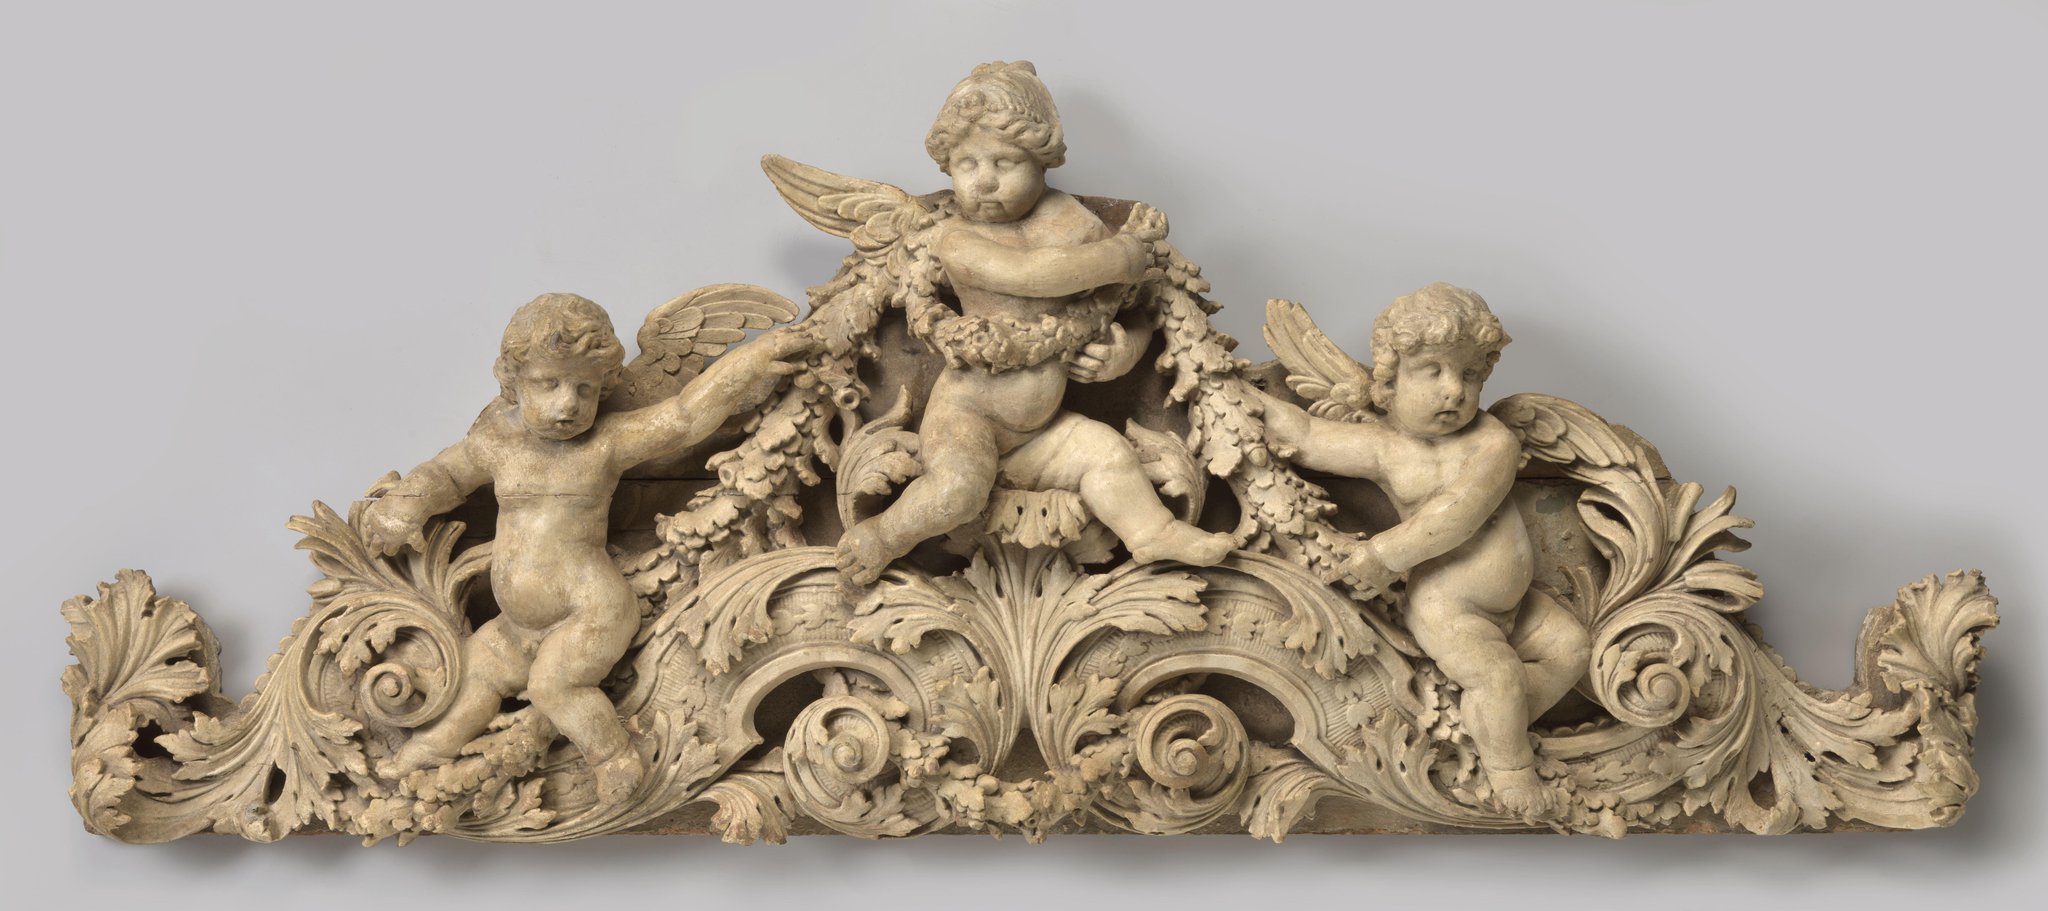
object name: portiek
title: Opzetstuk van een portiek met drie putti met guirlandes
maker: Anonymous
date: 1687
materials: wood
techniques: painted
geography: northern netherlands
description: Een gestoken gebeeldhouwd opzetstuk, afkomstig van een portiek (BK-1956-41-B-1) met in de cartouche van de bovendorpel het woord ANNO. Bij het opzetstuk horen vier losse voluten (BK-1956-41-B-3).